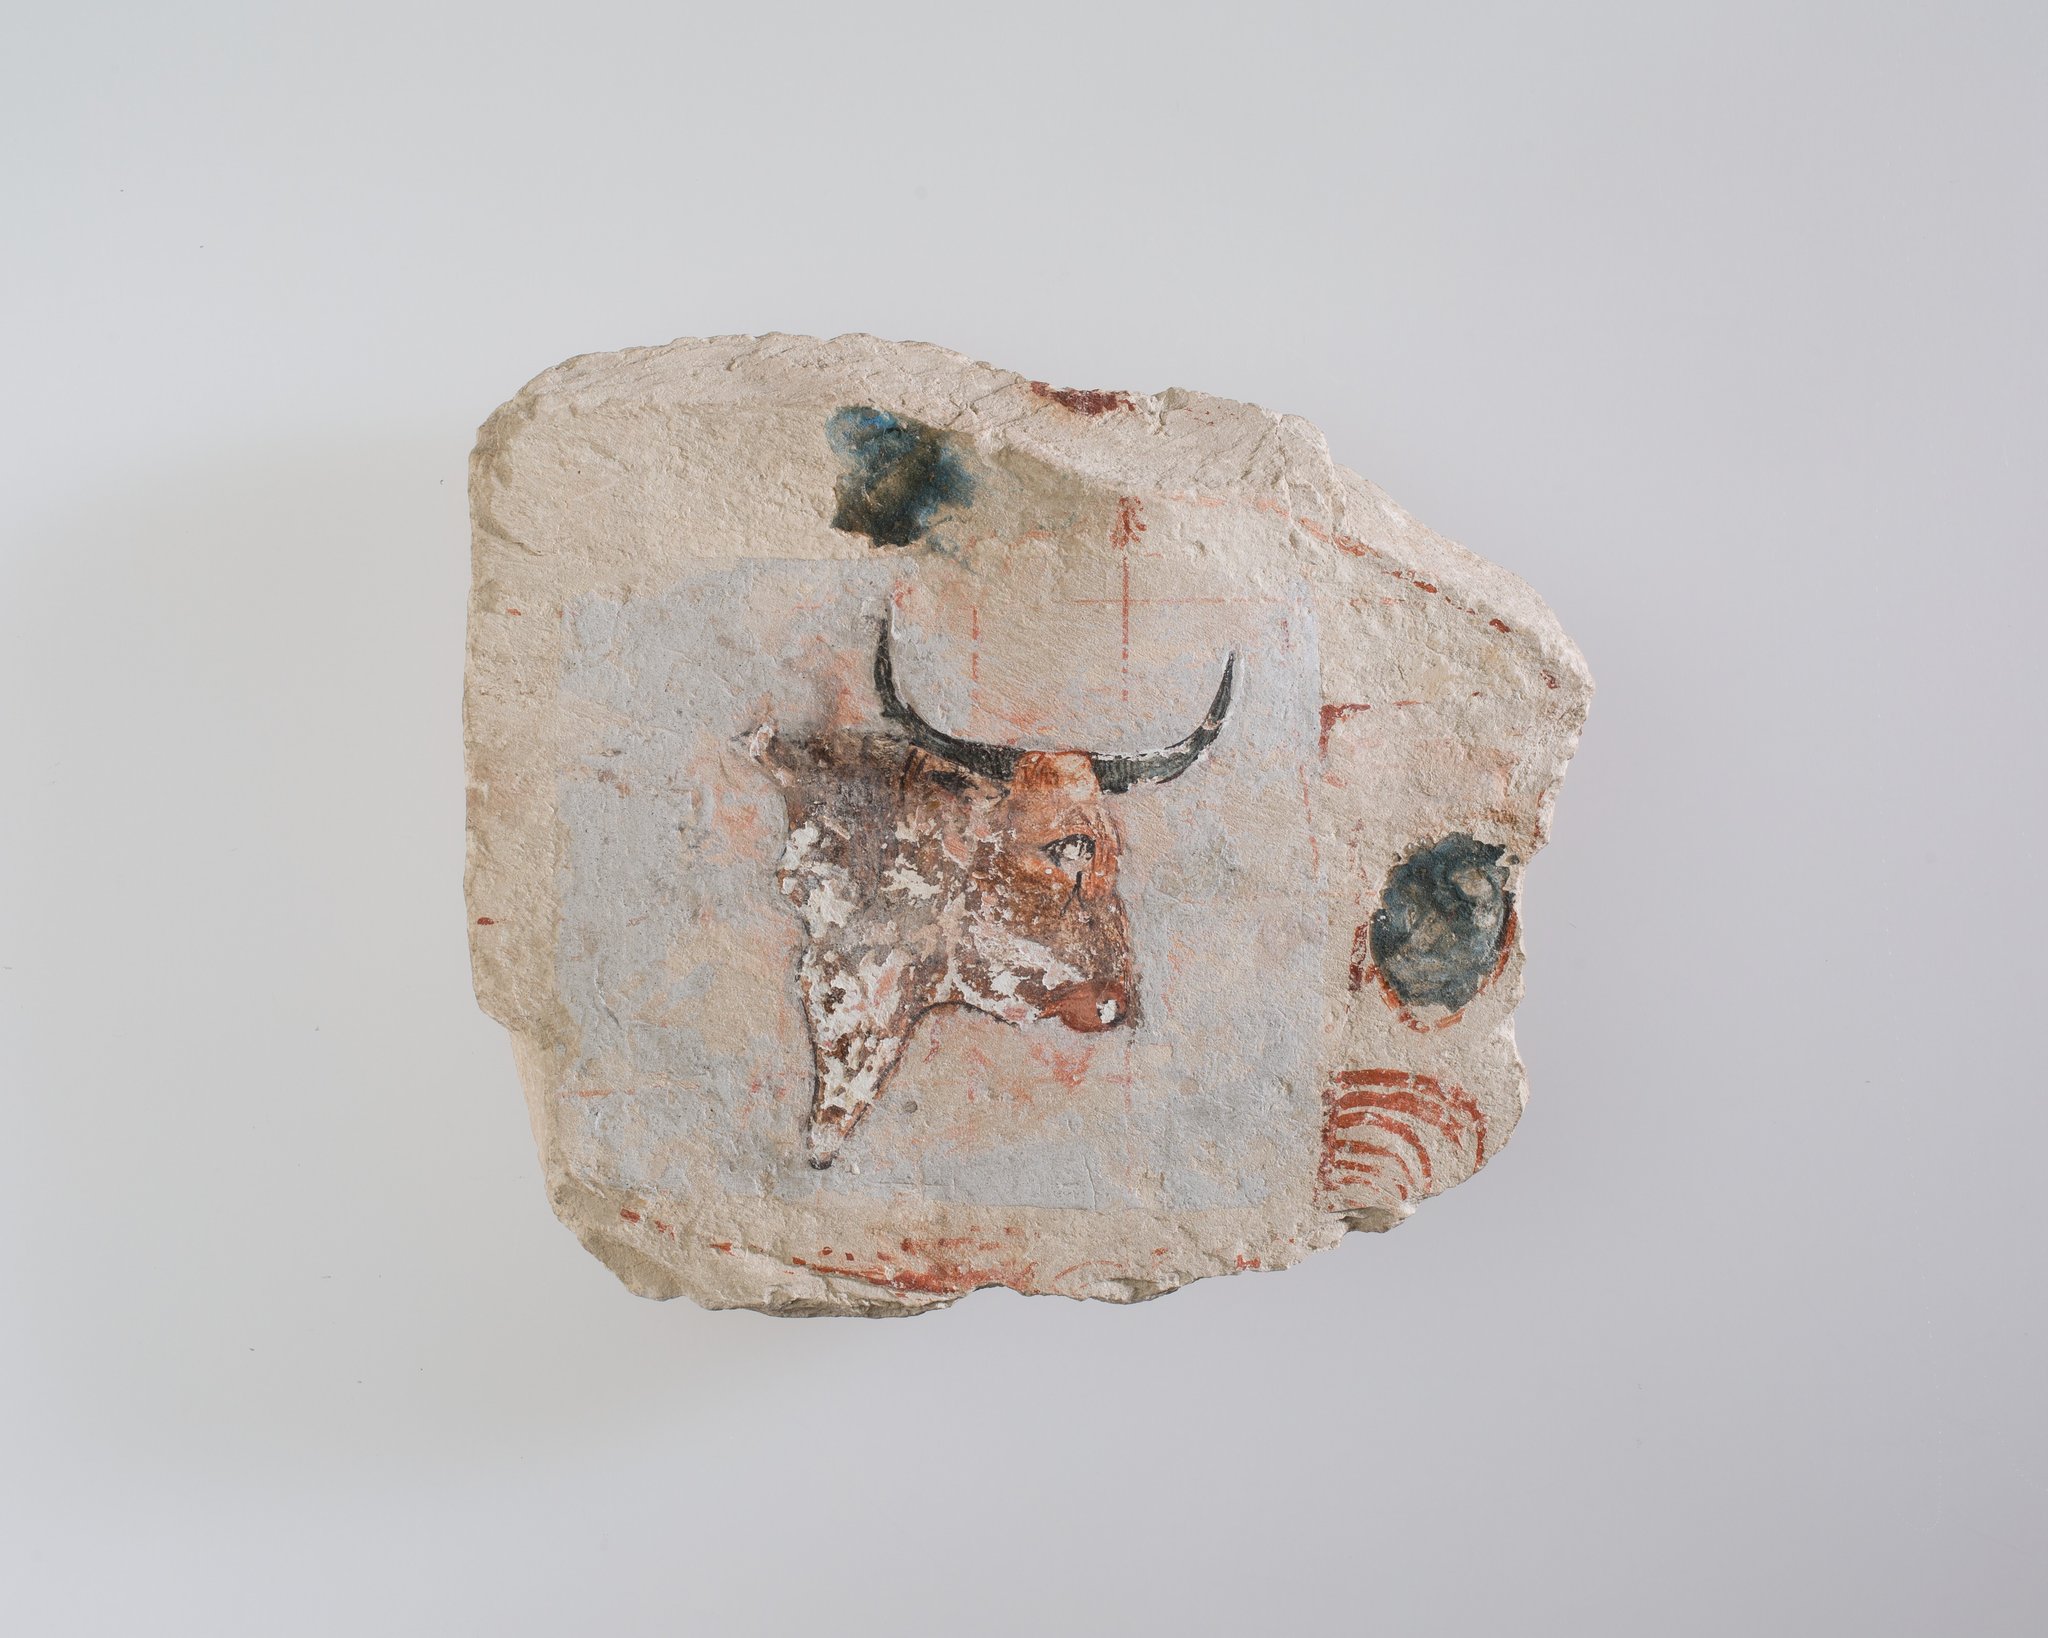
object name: ostracon, figured, bull's head, senenmut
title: Ostracon Depicting a Bull's Head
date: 1479-1458 BCE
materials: limestone, paint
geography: egypt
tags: bulls